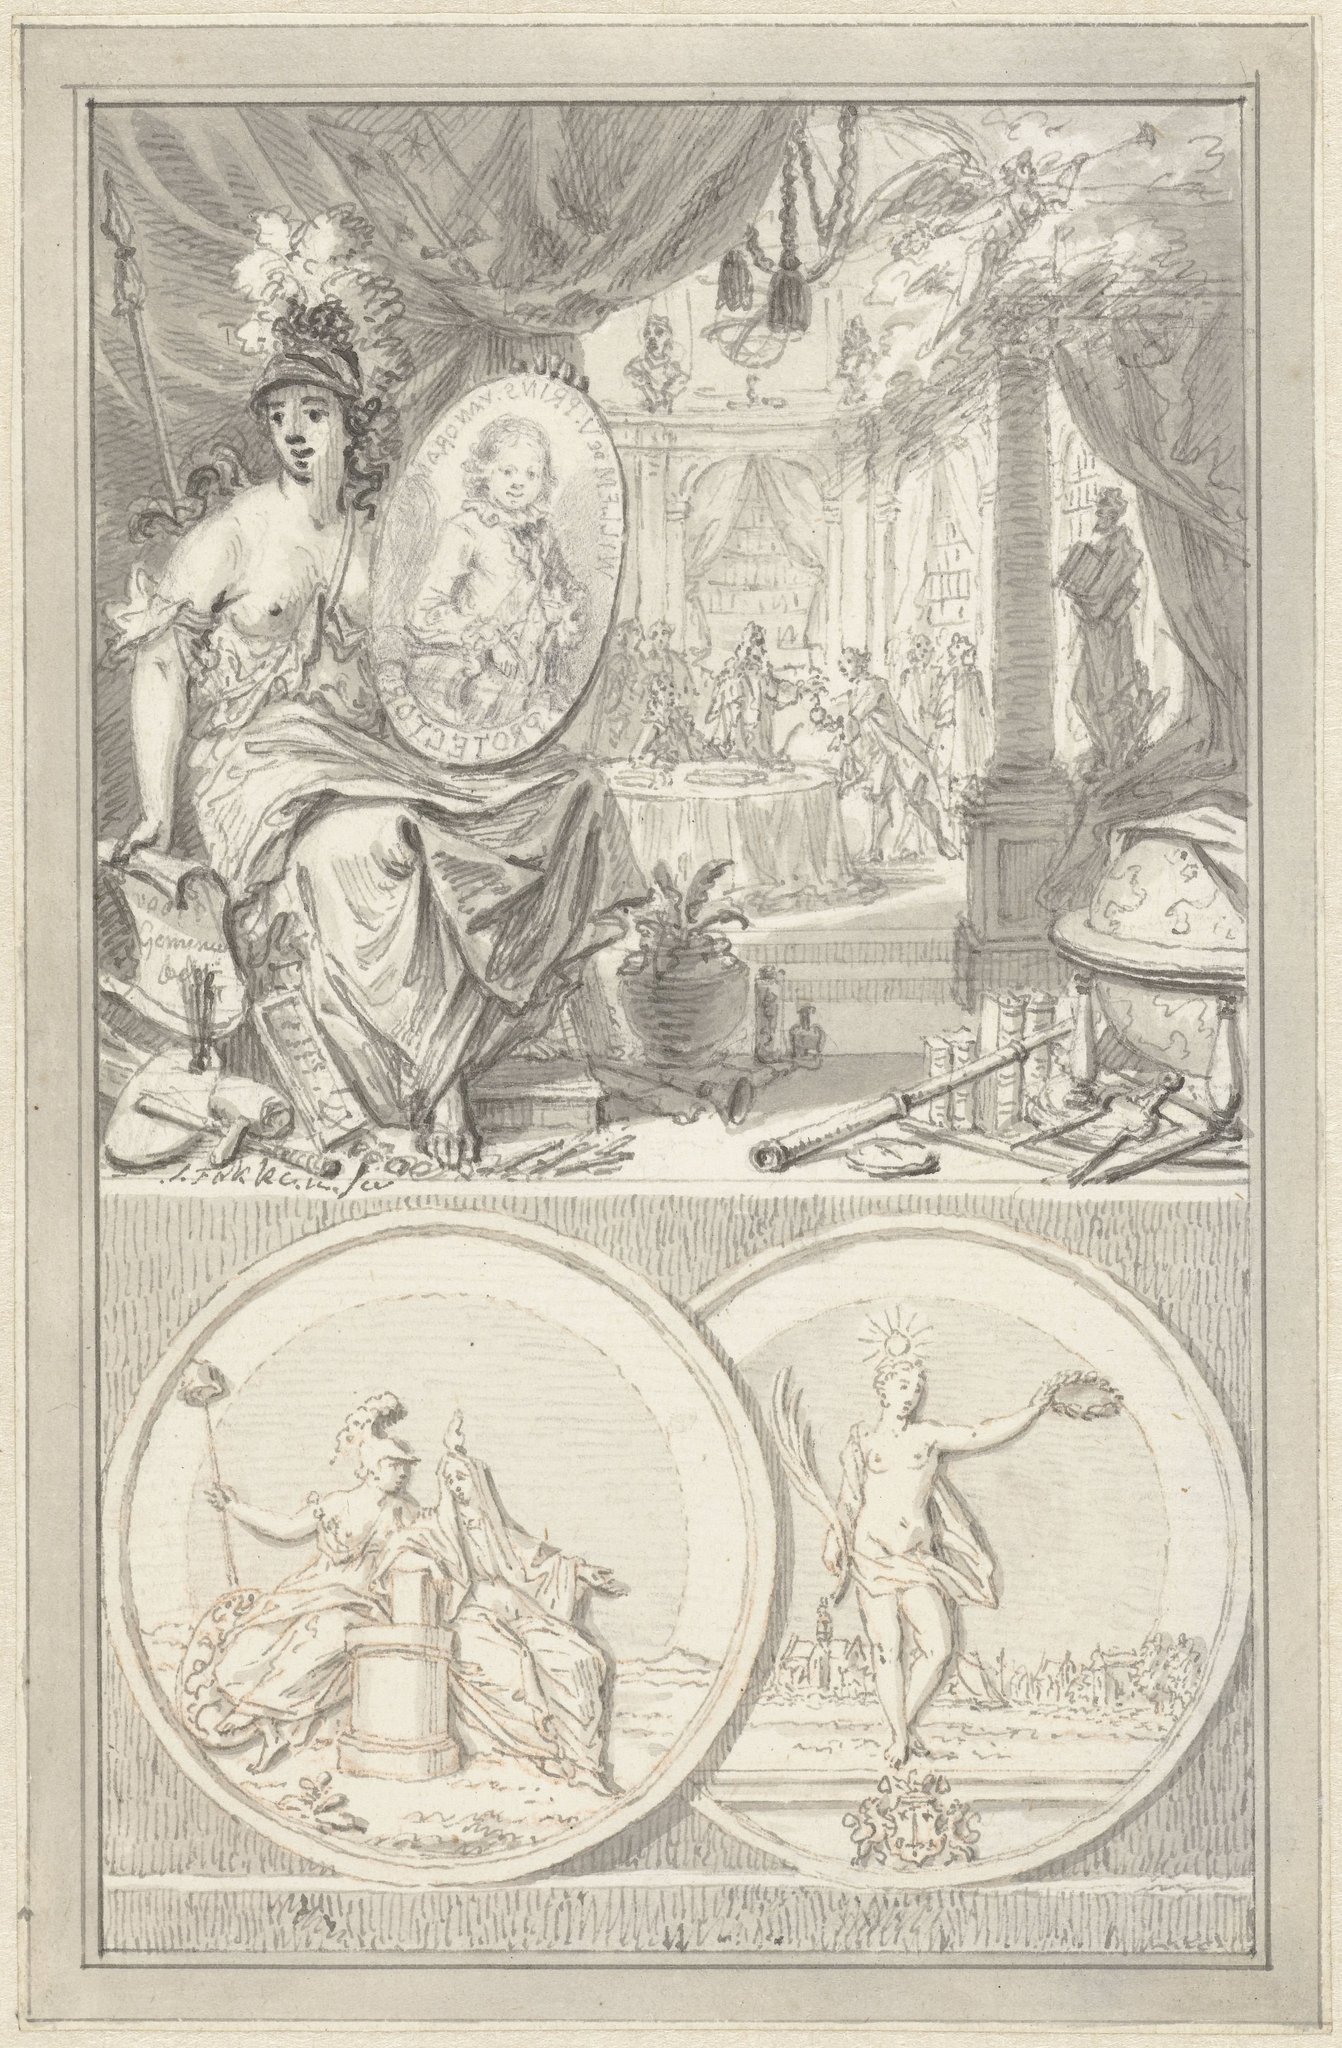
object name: drawing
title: Allegorie op de oprichting van de Hollandsche Maatschappij der Wetenschappen, 1752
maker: simon fokke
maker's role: draughtsman, print maker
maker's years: 1712-1784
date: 1752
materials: chalk, paper, pencil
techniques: pouncing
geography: northern netherlands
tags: the hague, william v (prince of orange), learned society, academy of sciences, minerva as patroness, symbolic representations, allegories and emblems ~ science, 'scientia'; 'scienza', 'studio' (ripa), names of organizations, companies, trade unions, etc., historical events and situations, haarlem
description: Allegorie op de oprichting van de Hollandsche Maatschappij der Wetenschappen te Haarlem op 21 mei 1752. Boven Minerva met een portret van de beschermheer prins Willem V, op de achtergrond een bijeenkomst van wetenschappers. Onder de zijden van een gedenkpenning met naakte Waarheid met zon op hoofd, houdt in linkerhand een palmtak en in rechterhand een olijfkrans; op achtergrond gezicht op stad Haarlem aan het Spaarne, onderaan het stadswapen van Haarlem. Keerzijde: twee vrouwen zittend bij altaar, voorstellend Godsdienst met vlam op hoofd en leunend op bijbel en Nederland met wapenschild en vrijheidshoed op speer. Ontwerp voor een prent.